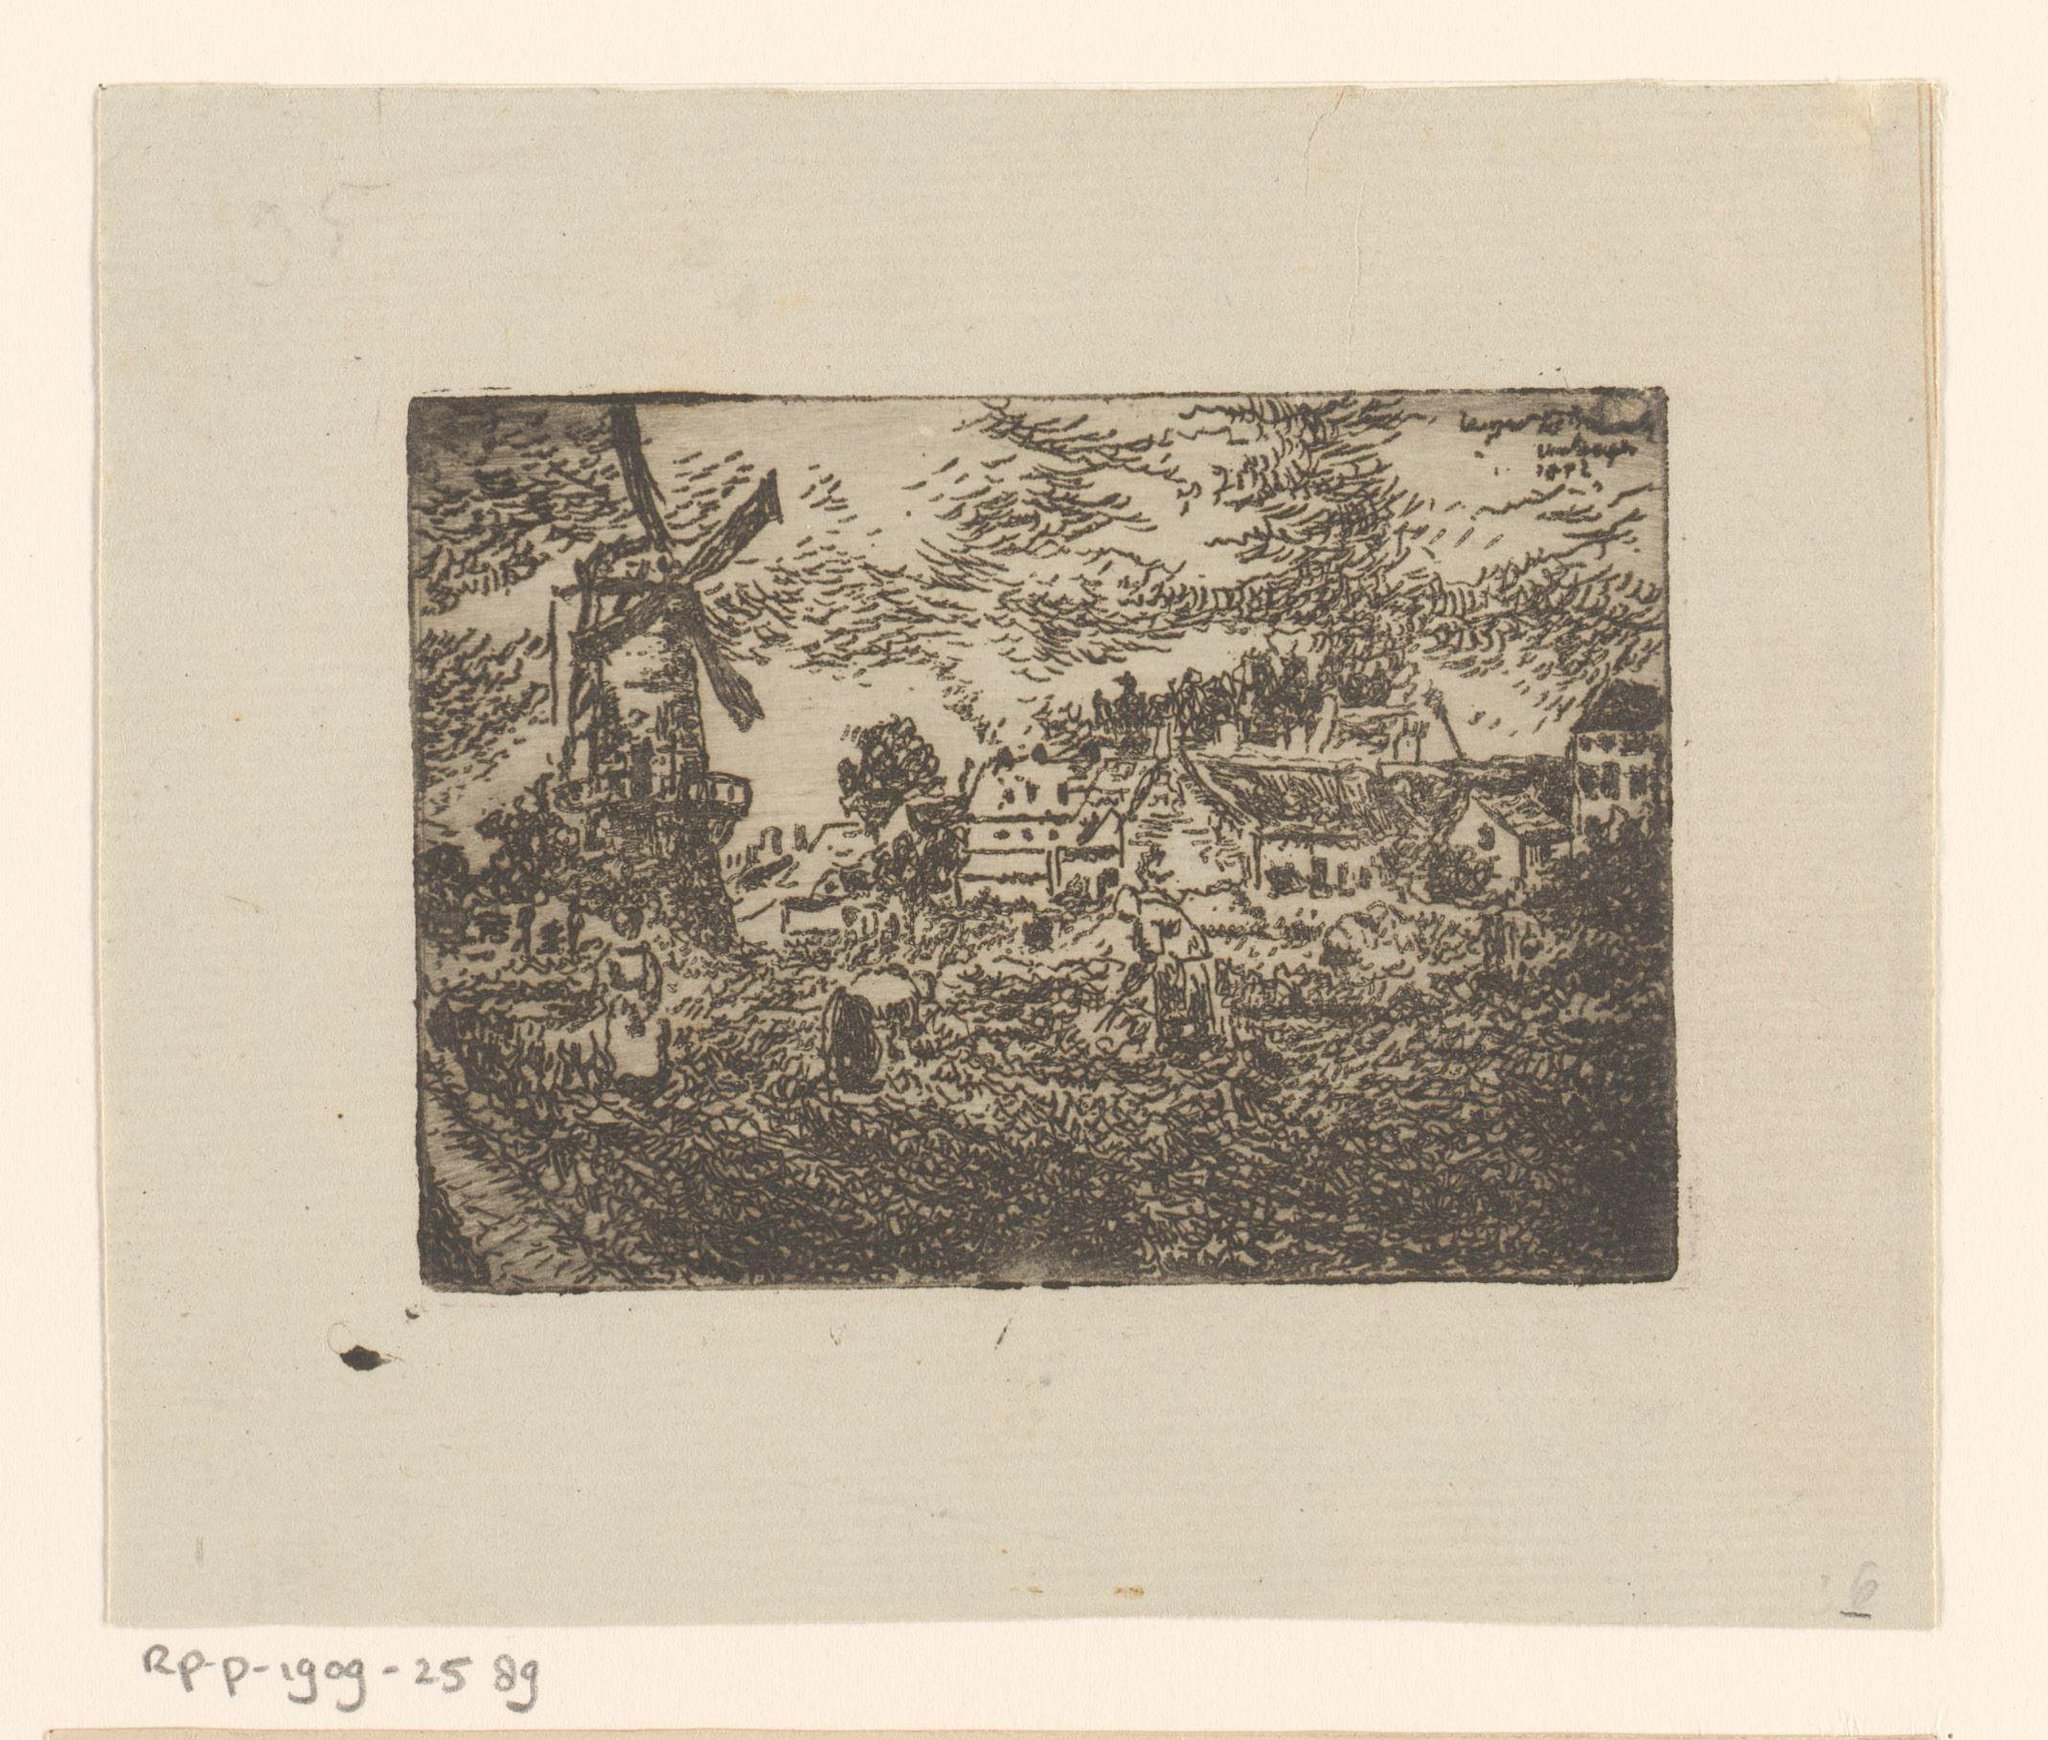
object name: print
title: De aardappeloogst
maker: henri de braekeleer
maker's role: draughtsman, print maker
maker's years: 1840-1888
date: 1875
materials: paper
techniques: etching, intaglio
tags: harvest, village, windmill in landscape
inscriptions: collector's mark: Lugt 2228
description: Mogelijk is de afgebeelde plaats Zurenborg.